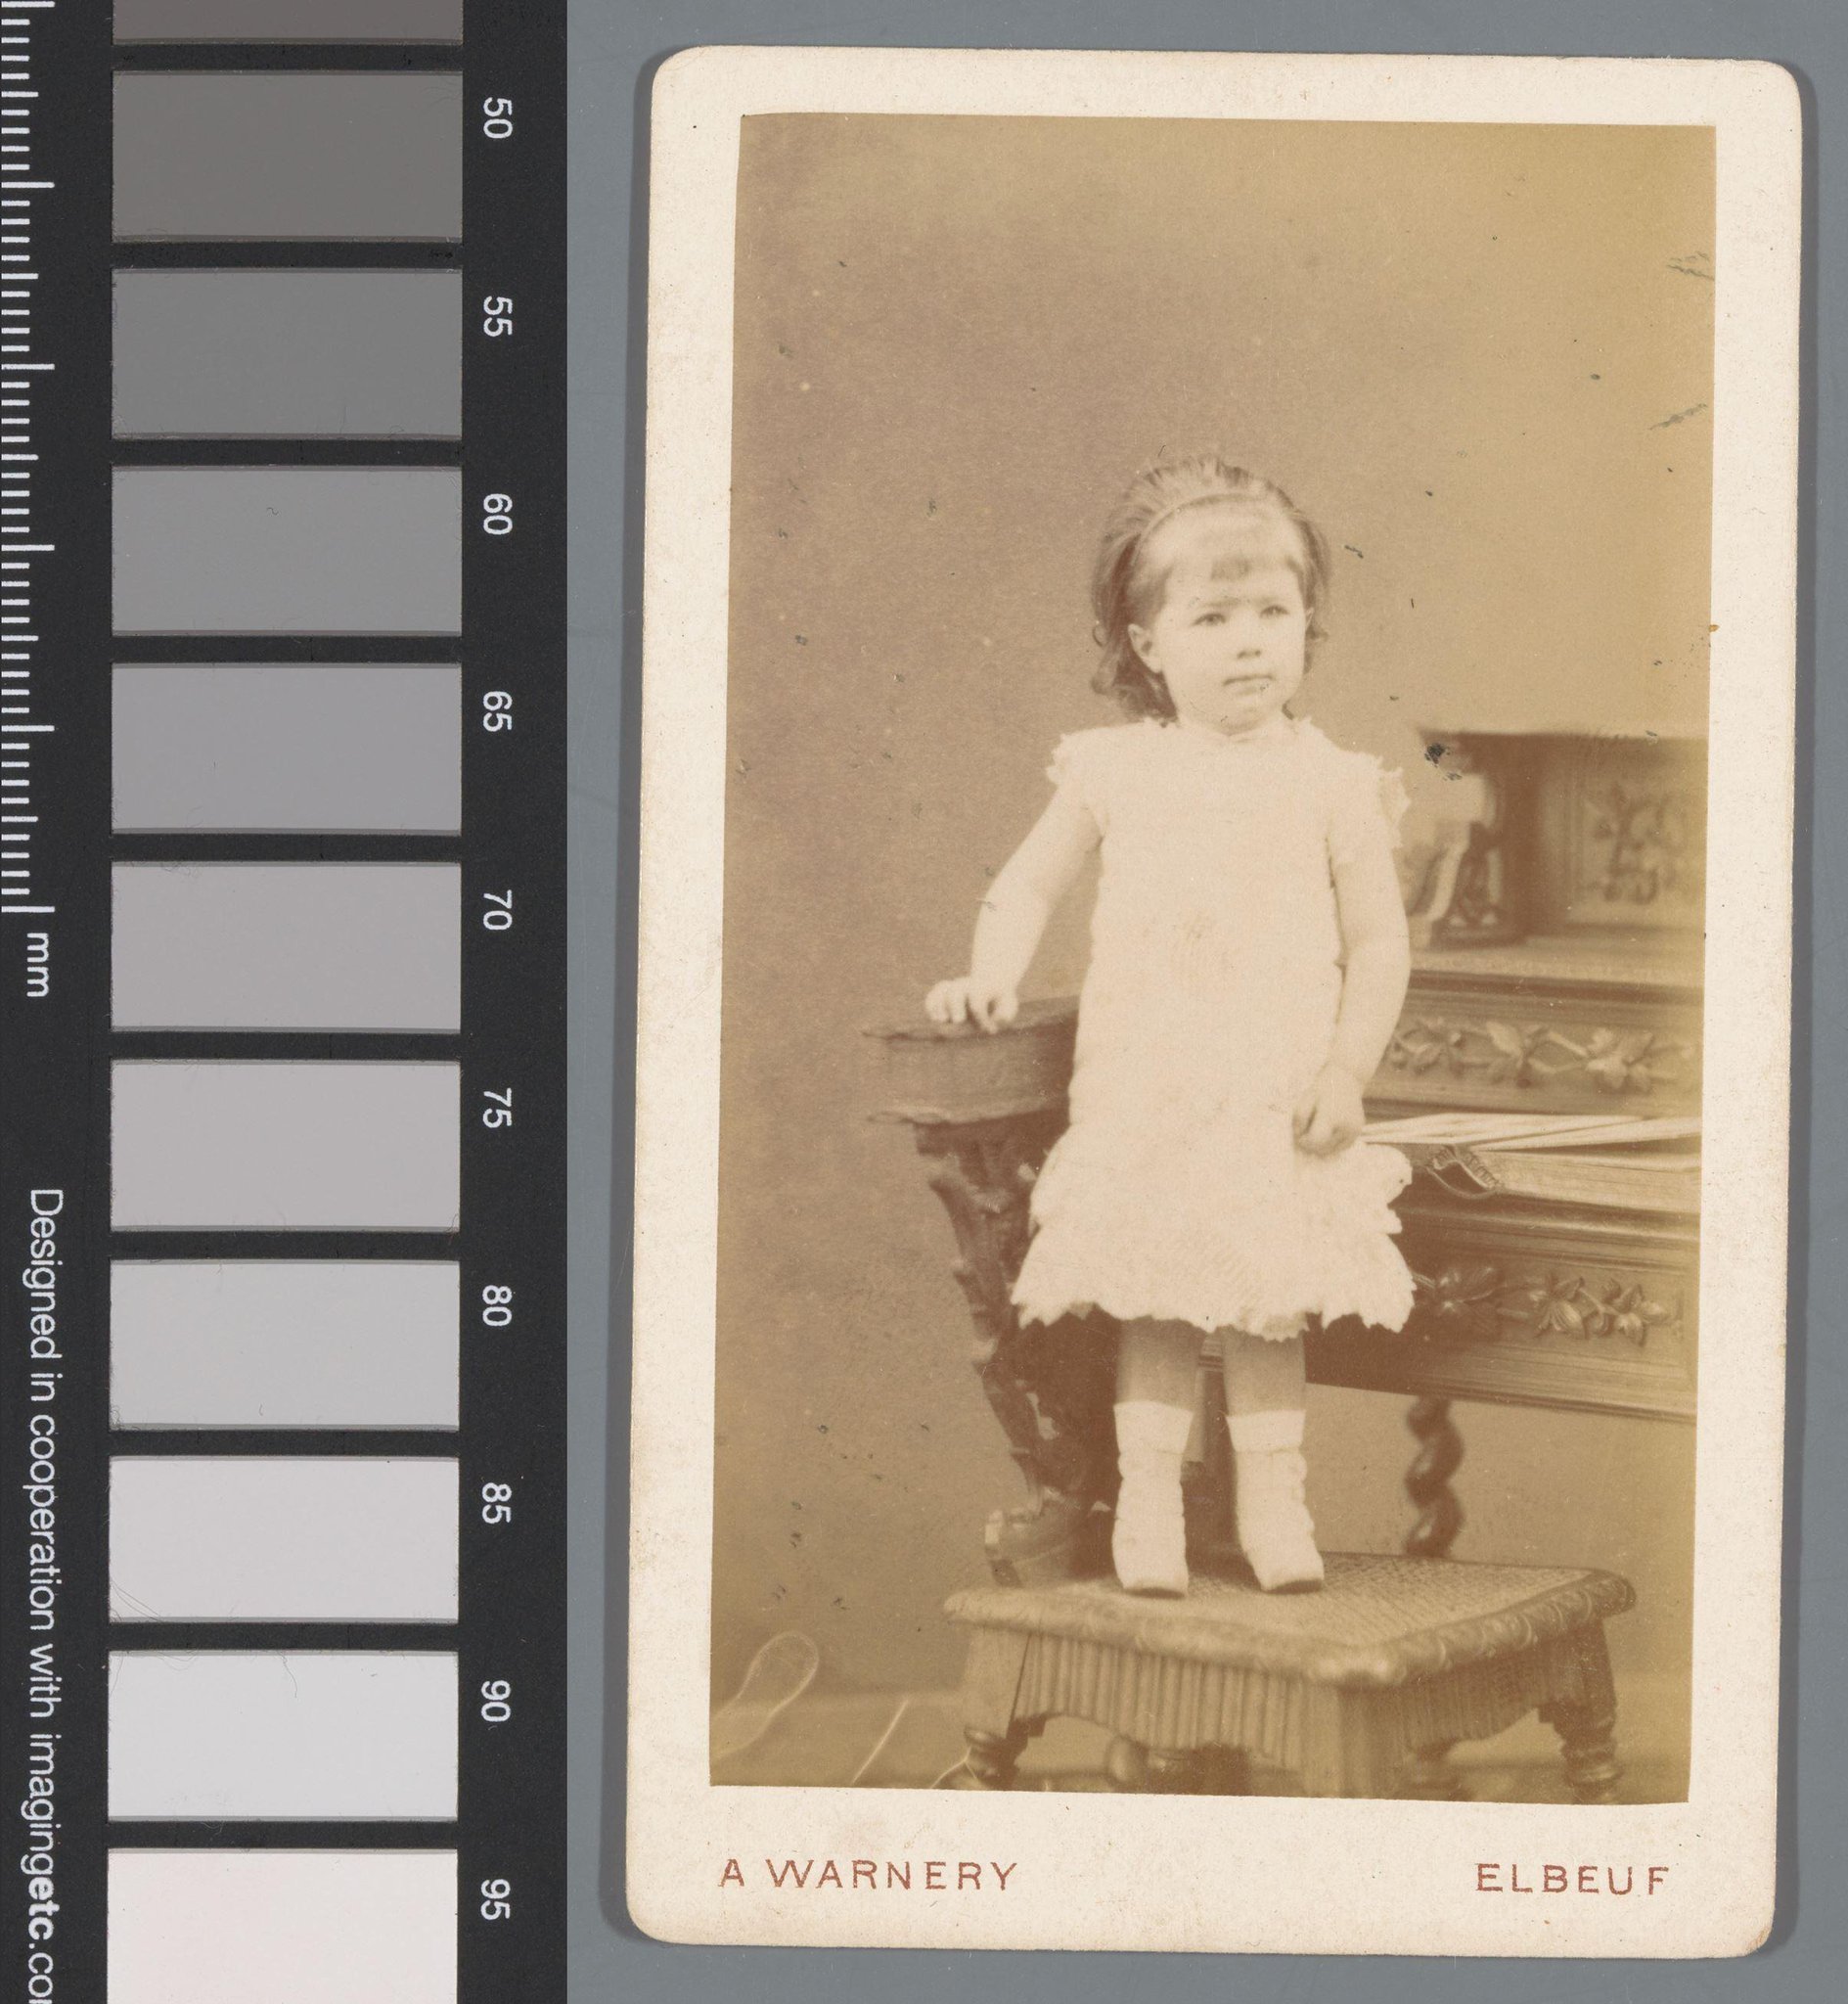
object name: photograph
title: Portret van een onbekend meisje op een stoel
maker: albert alfred warnery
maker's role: fotograaf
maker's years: 1853-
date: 1873-1885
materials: cardboard, paper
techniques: albumen print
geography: elbeuf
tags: girl (child between toddler and youth), anonymous historical person portrayed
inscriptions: address: ‘8, Rue St Auct, 8/ &/ 7, Rue de Paris, 7/ ANCIENNE MAISON DELAMARE/ Elbeuf’